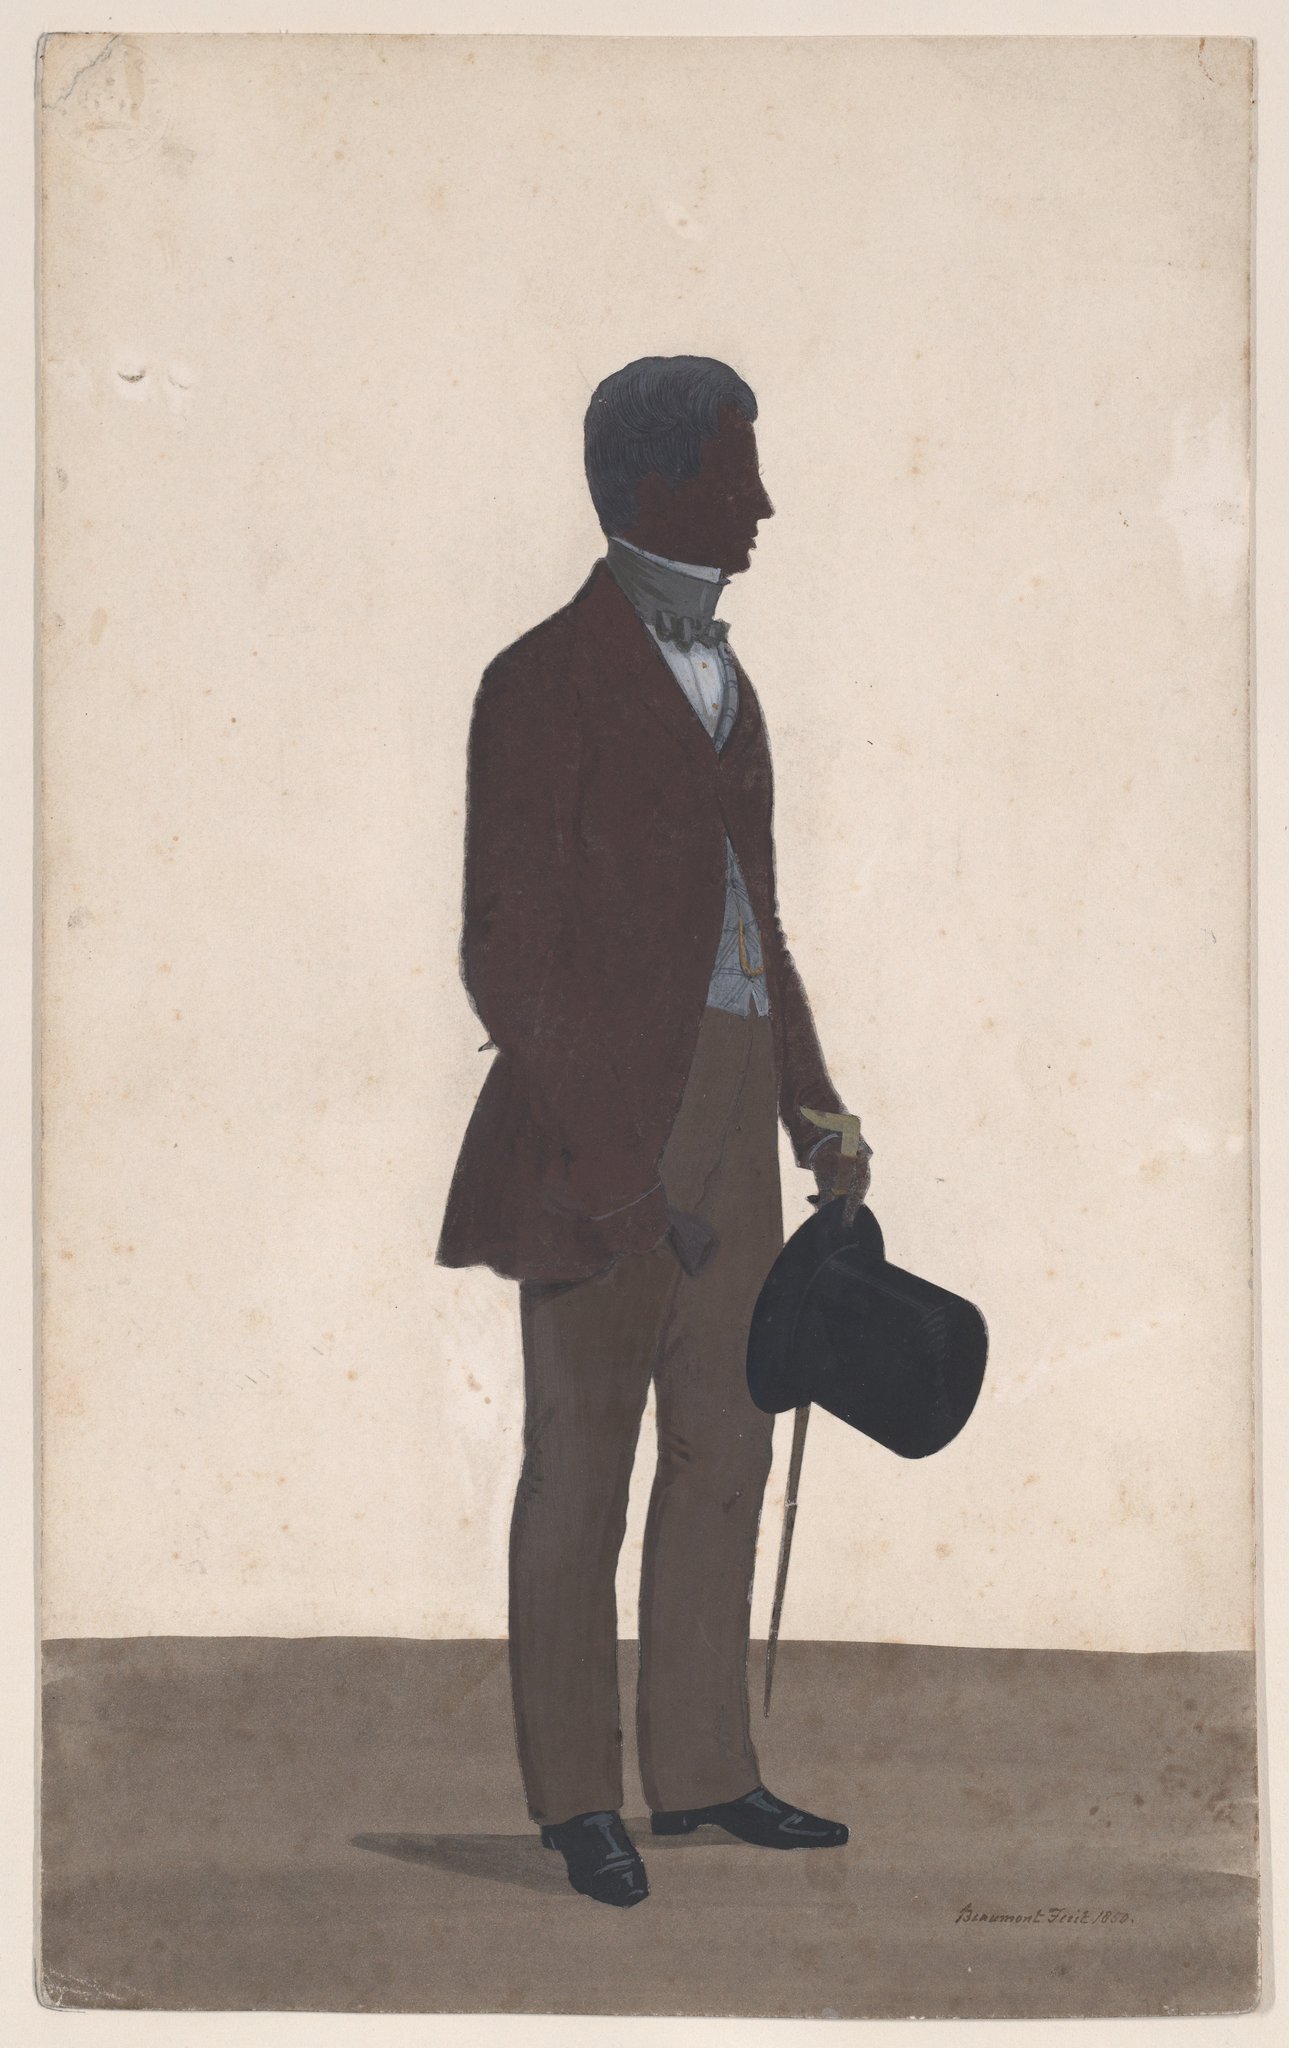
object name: cut paper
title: A young man, standing; full length silhouette, profile to right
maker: w. h. beaumont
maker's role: artist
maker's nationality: british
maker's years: 1800-1900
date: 1850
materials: gouache, ink, paper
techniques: cutting, pen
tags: men